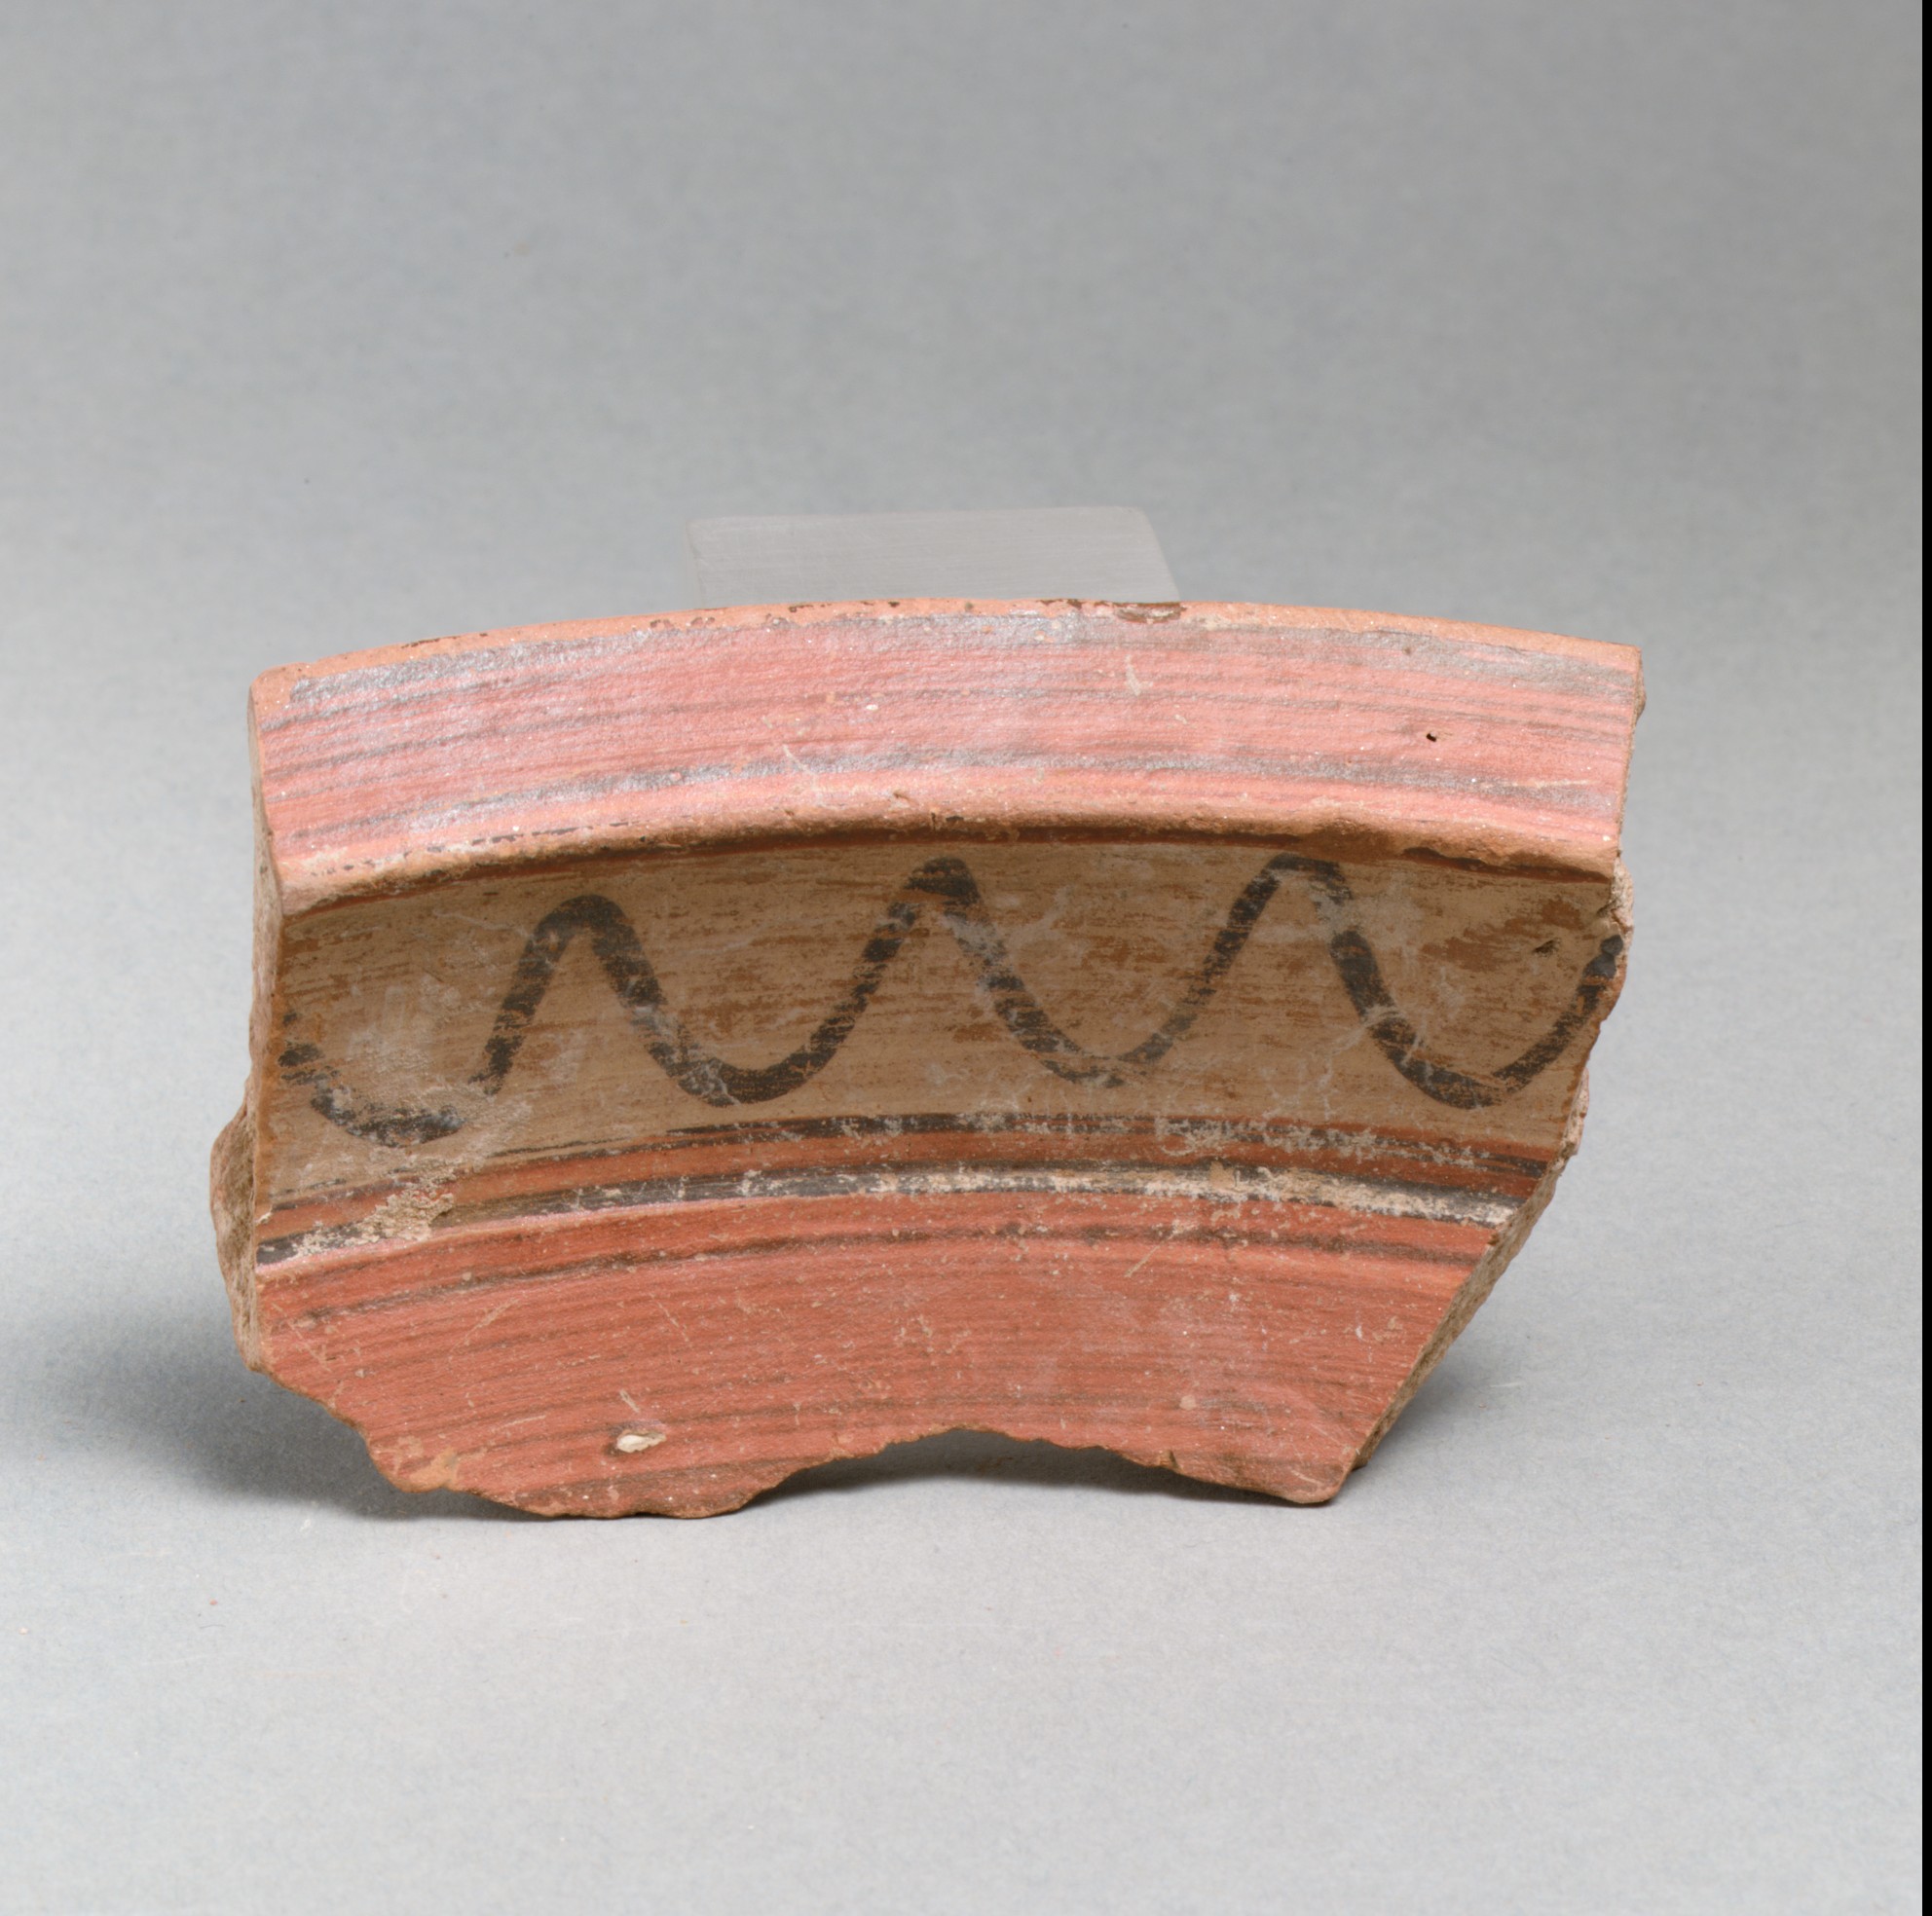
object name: vase fragment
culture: greek or lydian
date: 800-480 BCE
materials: terracotta